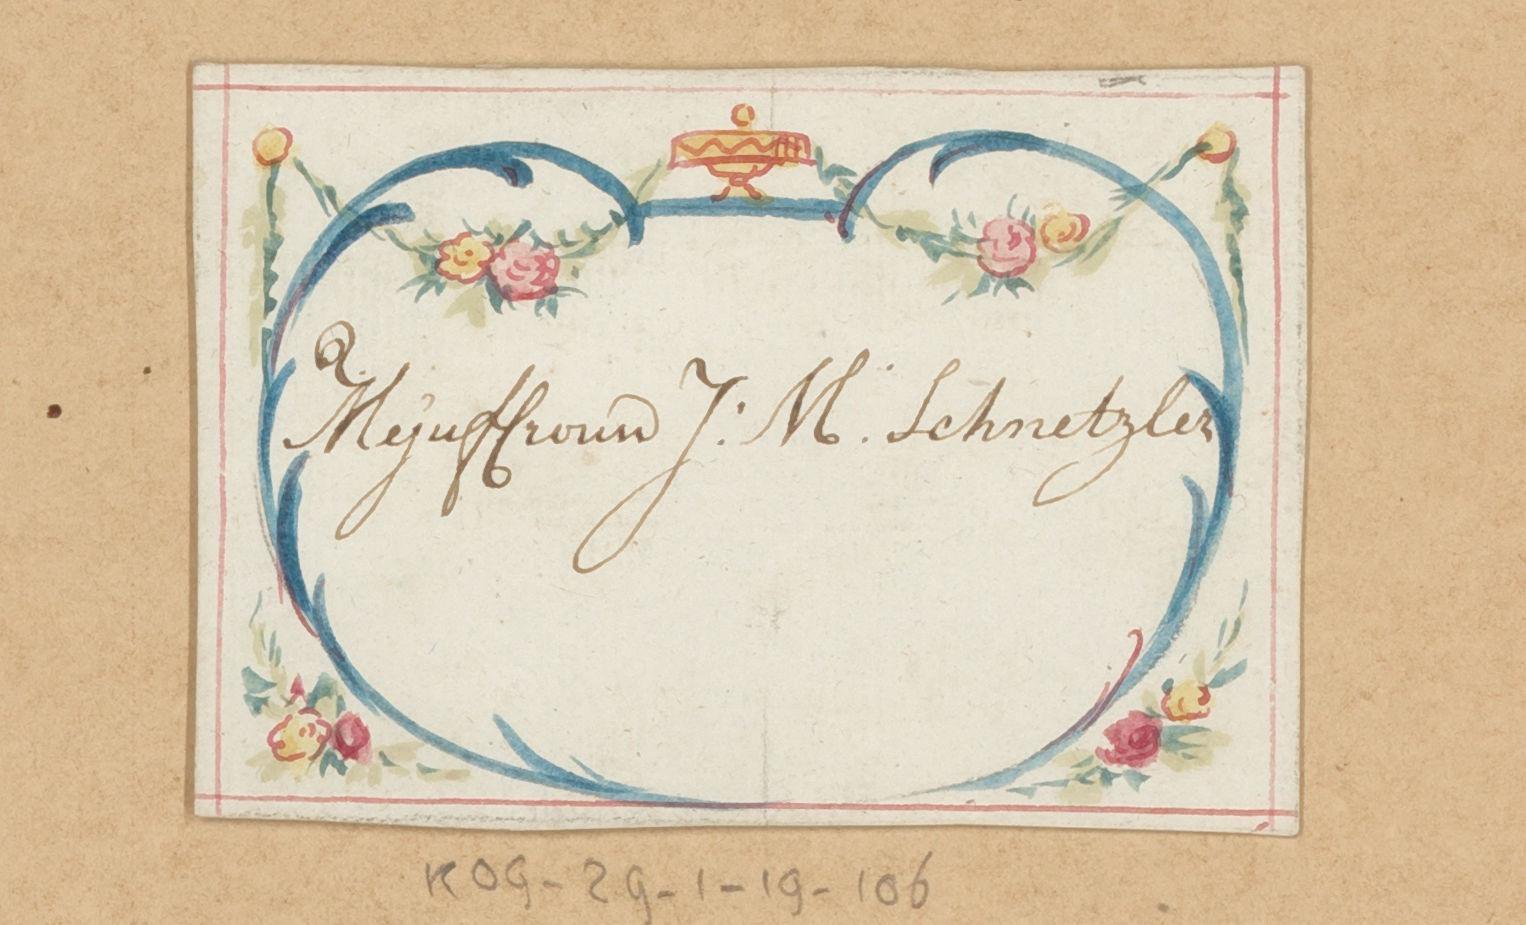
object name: drawing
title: Bruiloftskaart voor 'Mejuffrouw J: M: Schnetzler'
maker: Anonymous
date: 1780-1800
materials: paper, watercolor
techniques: brush, pen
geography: netherlands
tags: johanna magdalena schnetzler, wedding feast, wedding meal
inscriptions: collector's mark, collector's mark: Lugt 1641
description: Naamkaartje voor Johanna Magdalena Schnetzler (in 1792 gehuwd met Jean Bernard) te gebruiken bij de tafelindeling bij een bruiloftsmaal. Onderdeel van een groep van bruilofts- en invitatiekaartjes van de families Bernard en Metayer. Onderwerpsrubrieken binnen de Atlas Zeden en Gewoonten: Des Menschen Begin, Midden en Einde. Bruiloft en huwelijk.